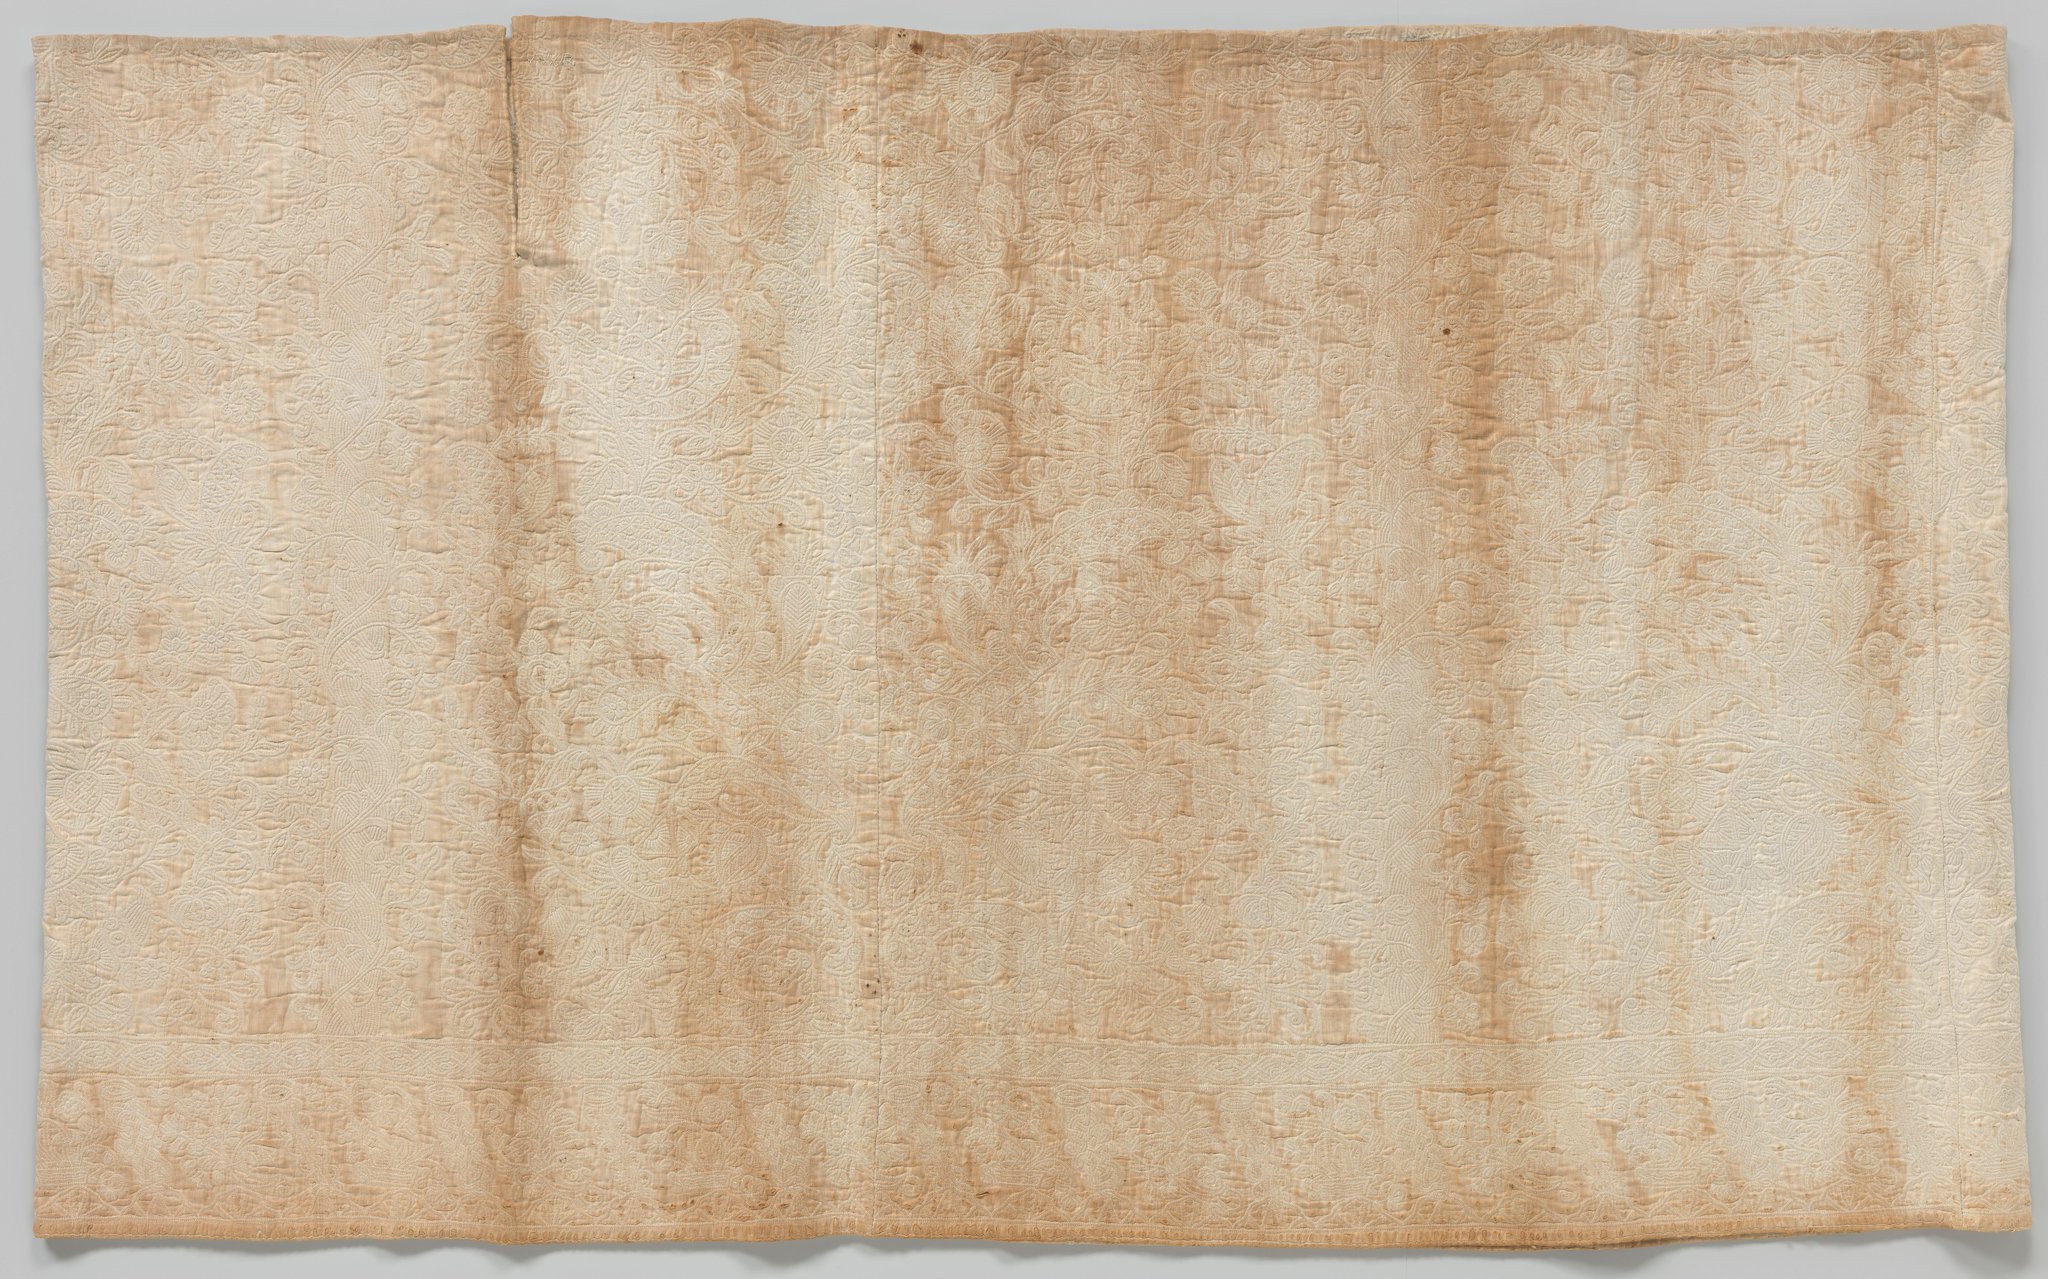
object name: womenswear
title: Rok van linnen, op een brede onderrand na, met een patroon van bloemen en bladeren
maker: Anonymous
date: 1740-1760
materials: linen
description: Gestikte linnen rok. aan de onderzijde een brede rand, het overige met bloemen en bladeren geheel overdekt.